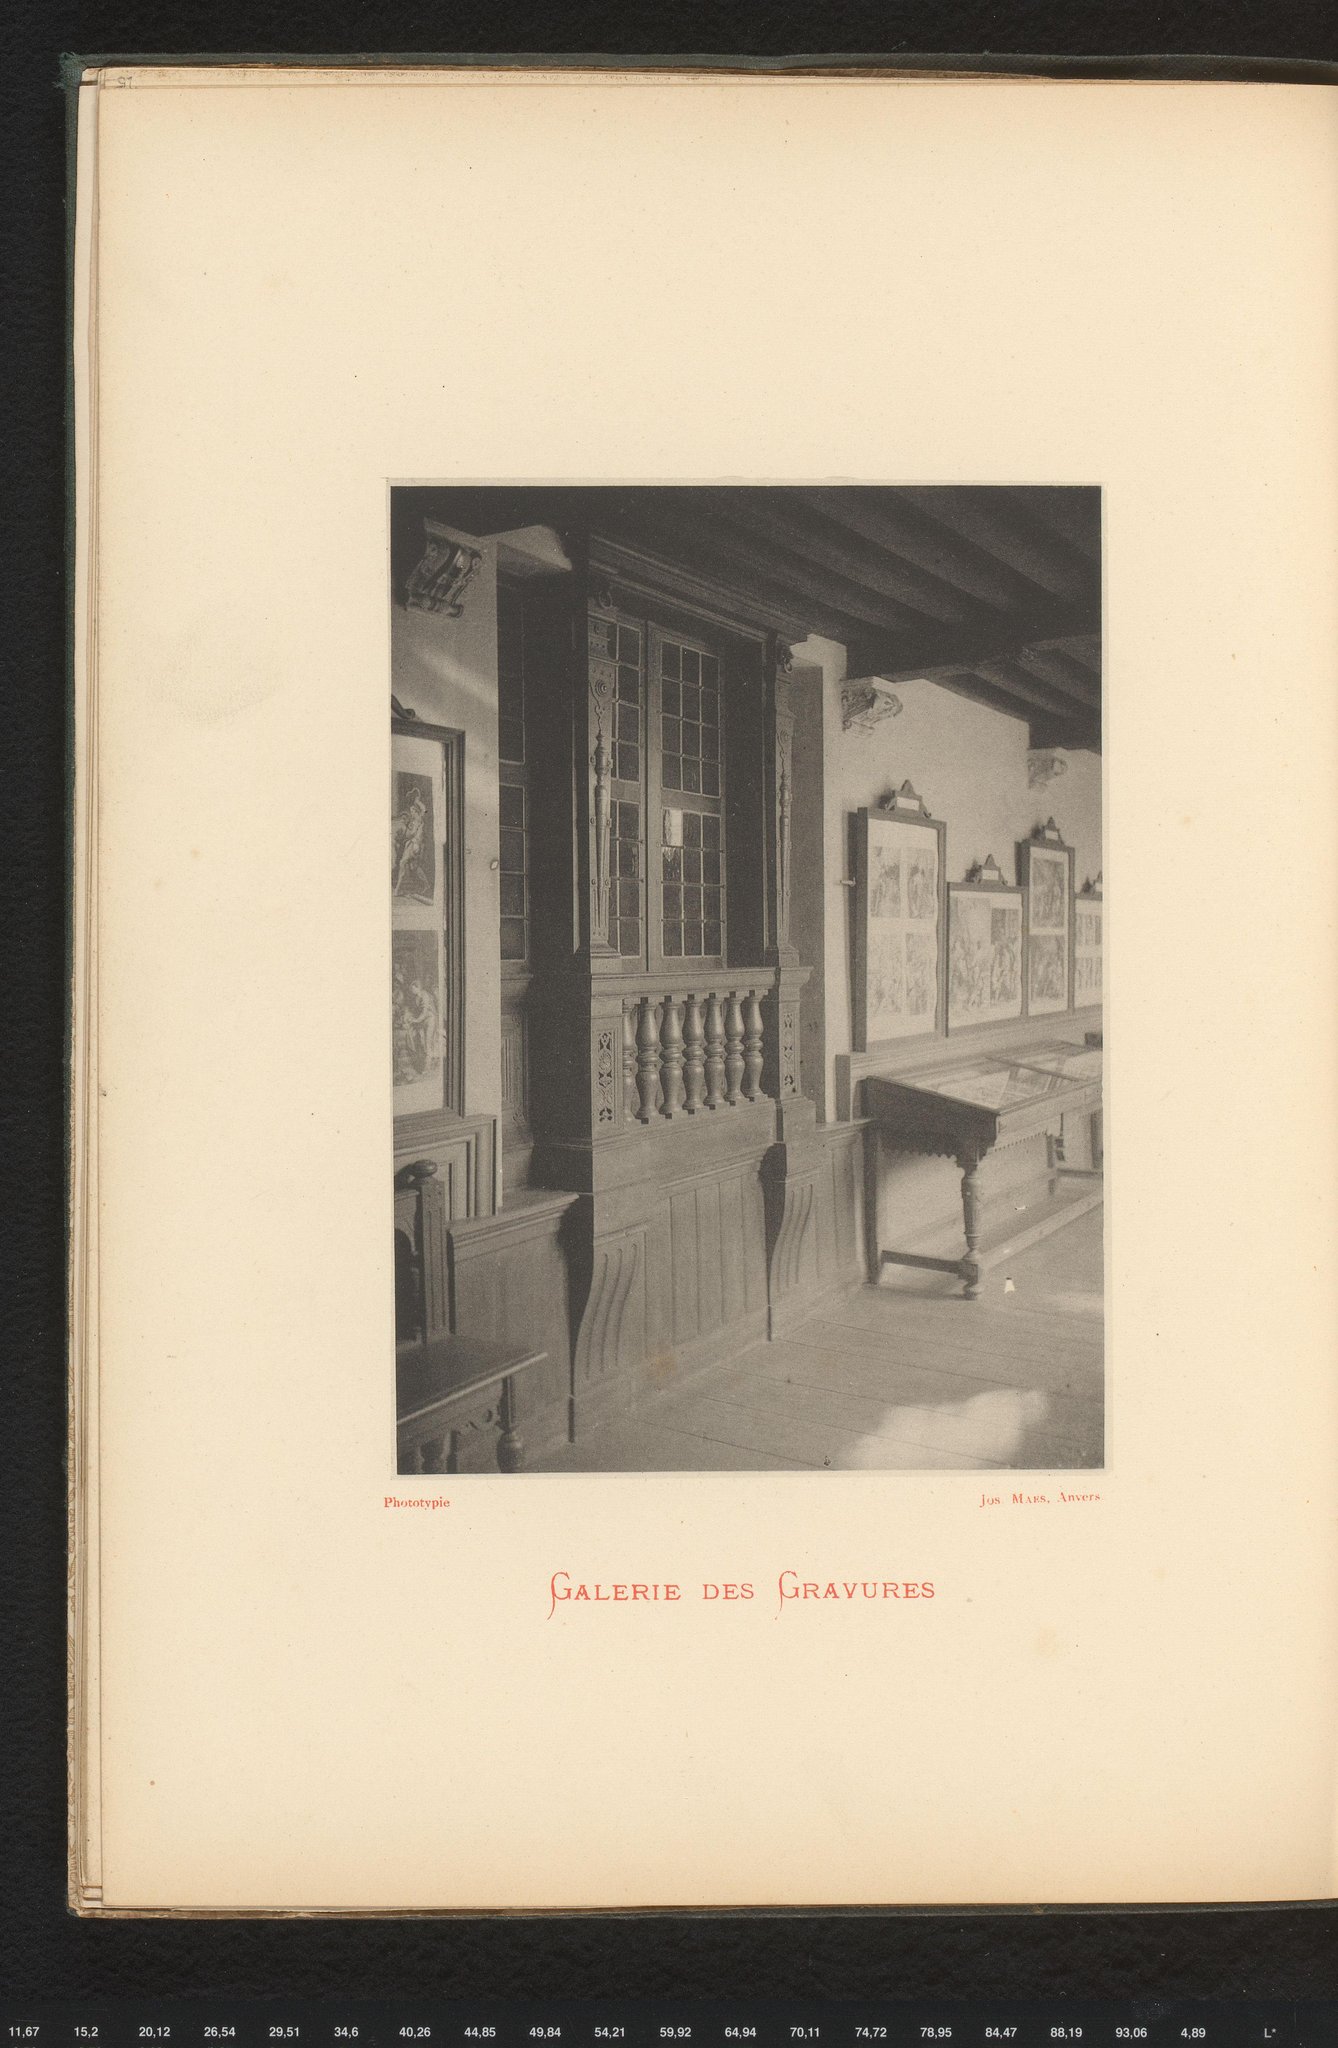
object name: photomechanical print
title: Kamer met tentoongestelde gravures in het huis van Christoffel Plantijn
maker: joseph maes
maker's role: fotograaf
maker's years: 1838-1908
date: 1877-1882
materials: paper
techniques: photograph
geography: antwerp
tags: print, e.g.: engraving, etching, lithograph, interior of the house